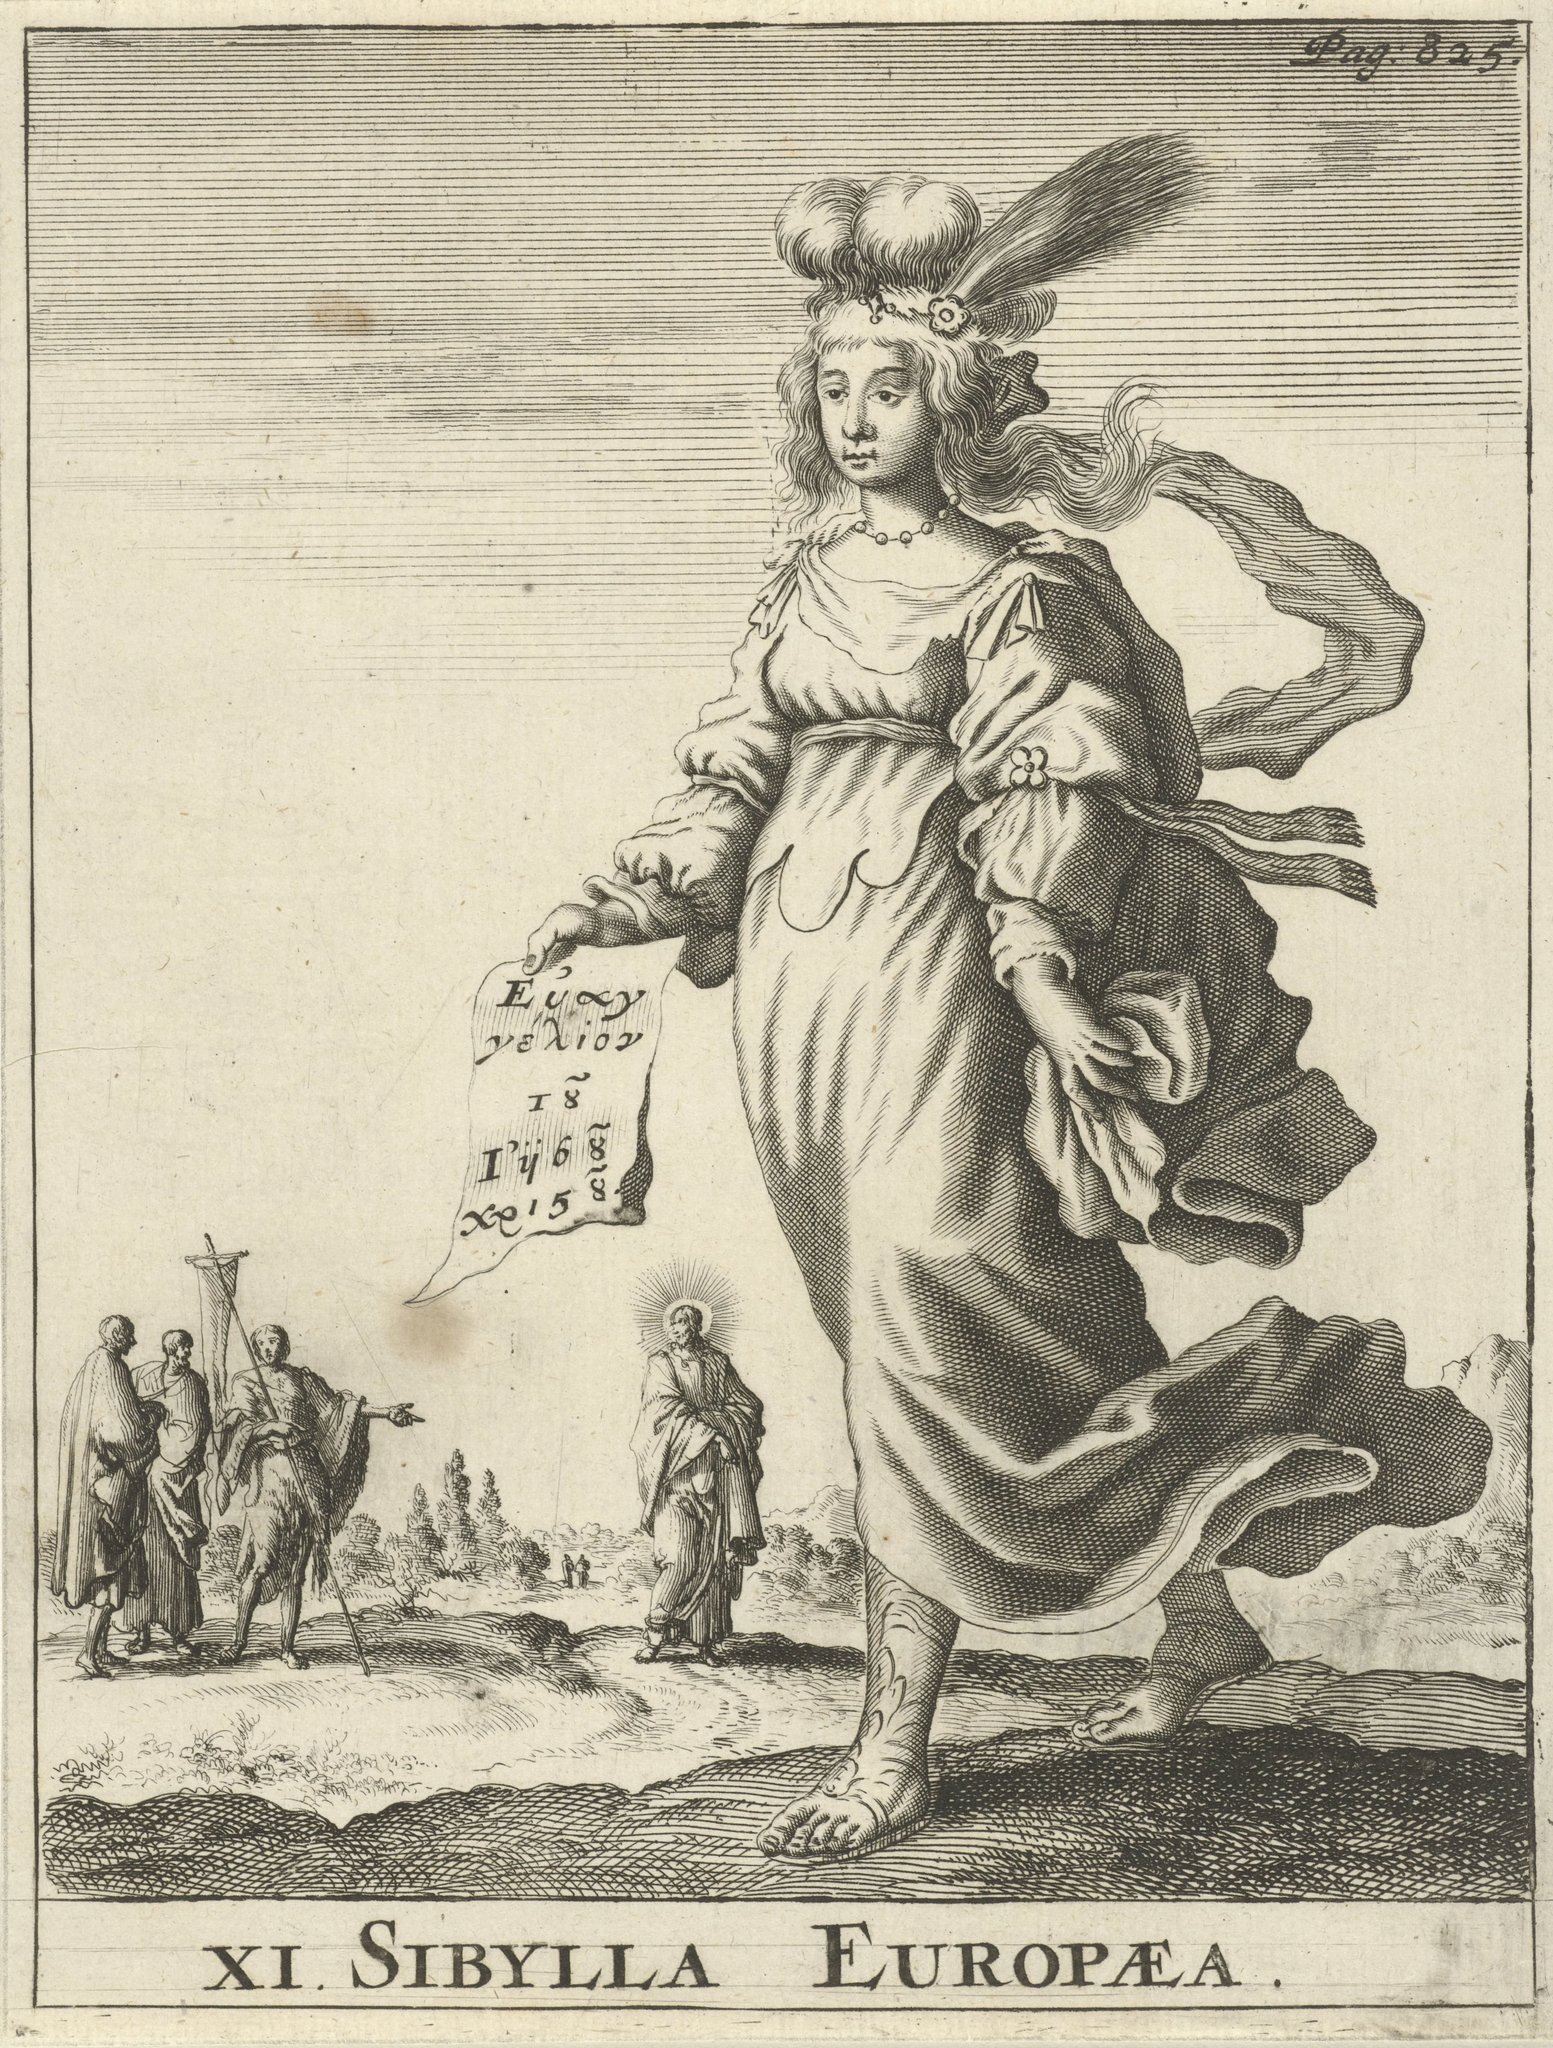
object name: print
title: Europese Sibille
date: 1684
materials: paper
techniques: engraving, etching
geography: amsterdam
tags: two disciples of john the baptist follow christ, sibyls (with name)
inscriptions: collector's mark: Lugt 2228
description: Europese Sibille. Op de achtergrond wijst Johannes de Doper zijn discipelen op Christus. Prent rechtsboven gemerkt: Pag: 825.